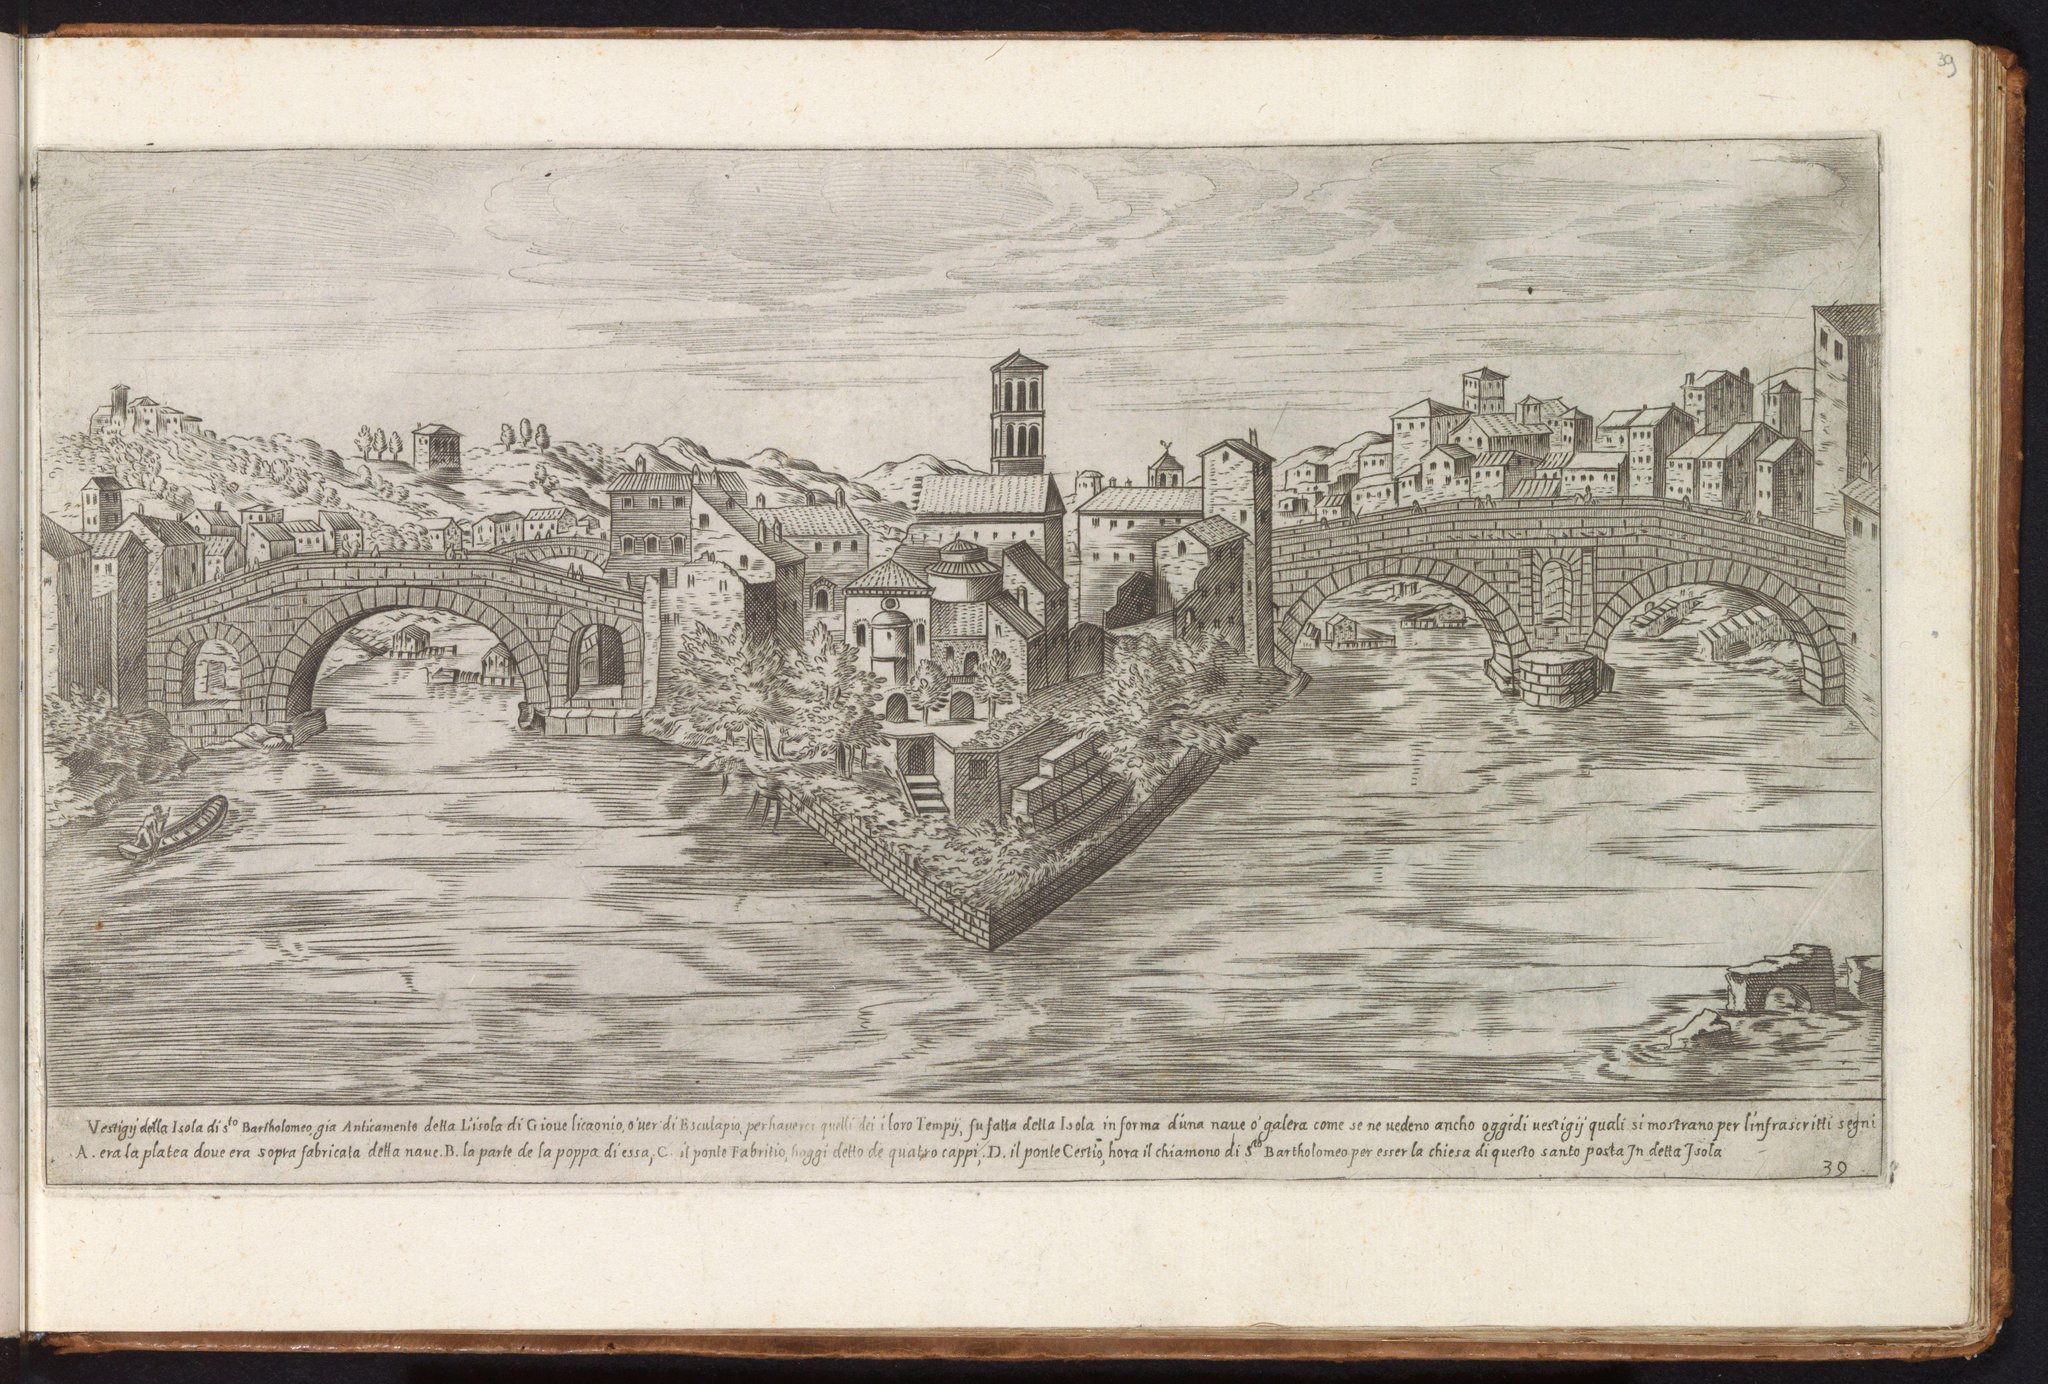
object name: album leaf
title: Tibereiland te Rome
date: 1575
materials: paper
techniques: engraving, etching, intaglio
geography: vatican city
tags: city-view, and landscape with man-made constructions, island, ruin of a building ~ architecture, theatre (building), bridge in city across river, canal, etc.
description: Gezicht op het Tibereiland tussen de Pons Cestius en de Pons Fabricius. Onderschrift in het Italiaans. Prent maakt deel uit van een album.